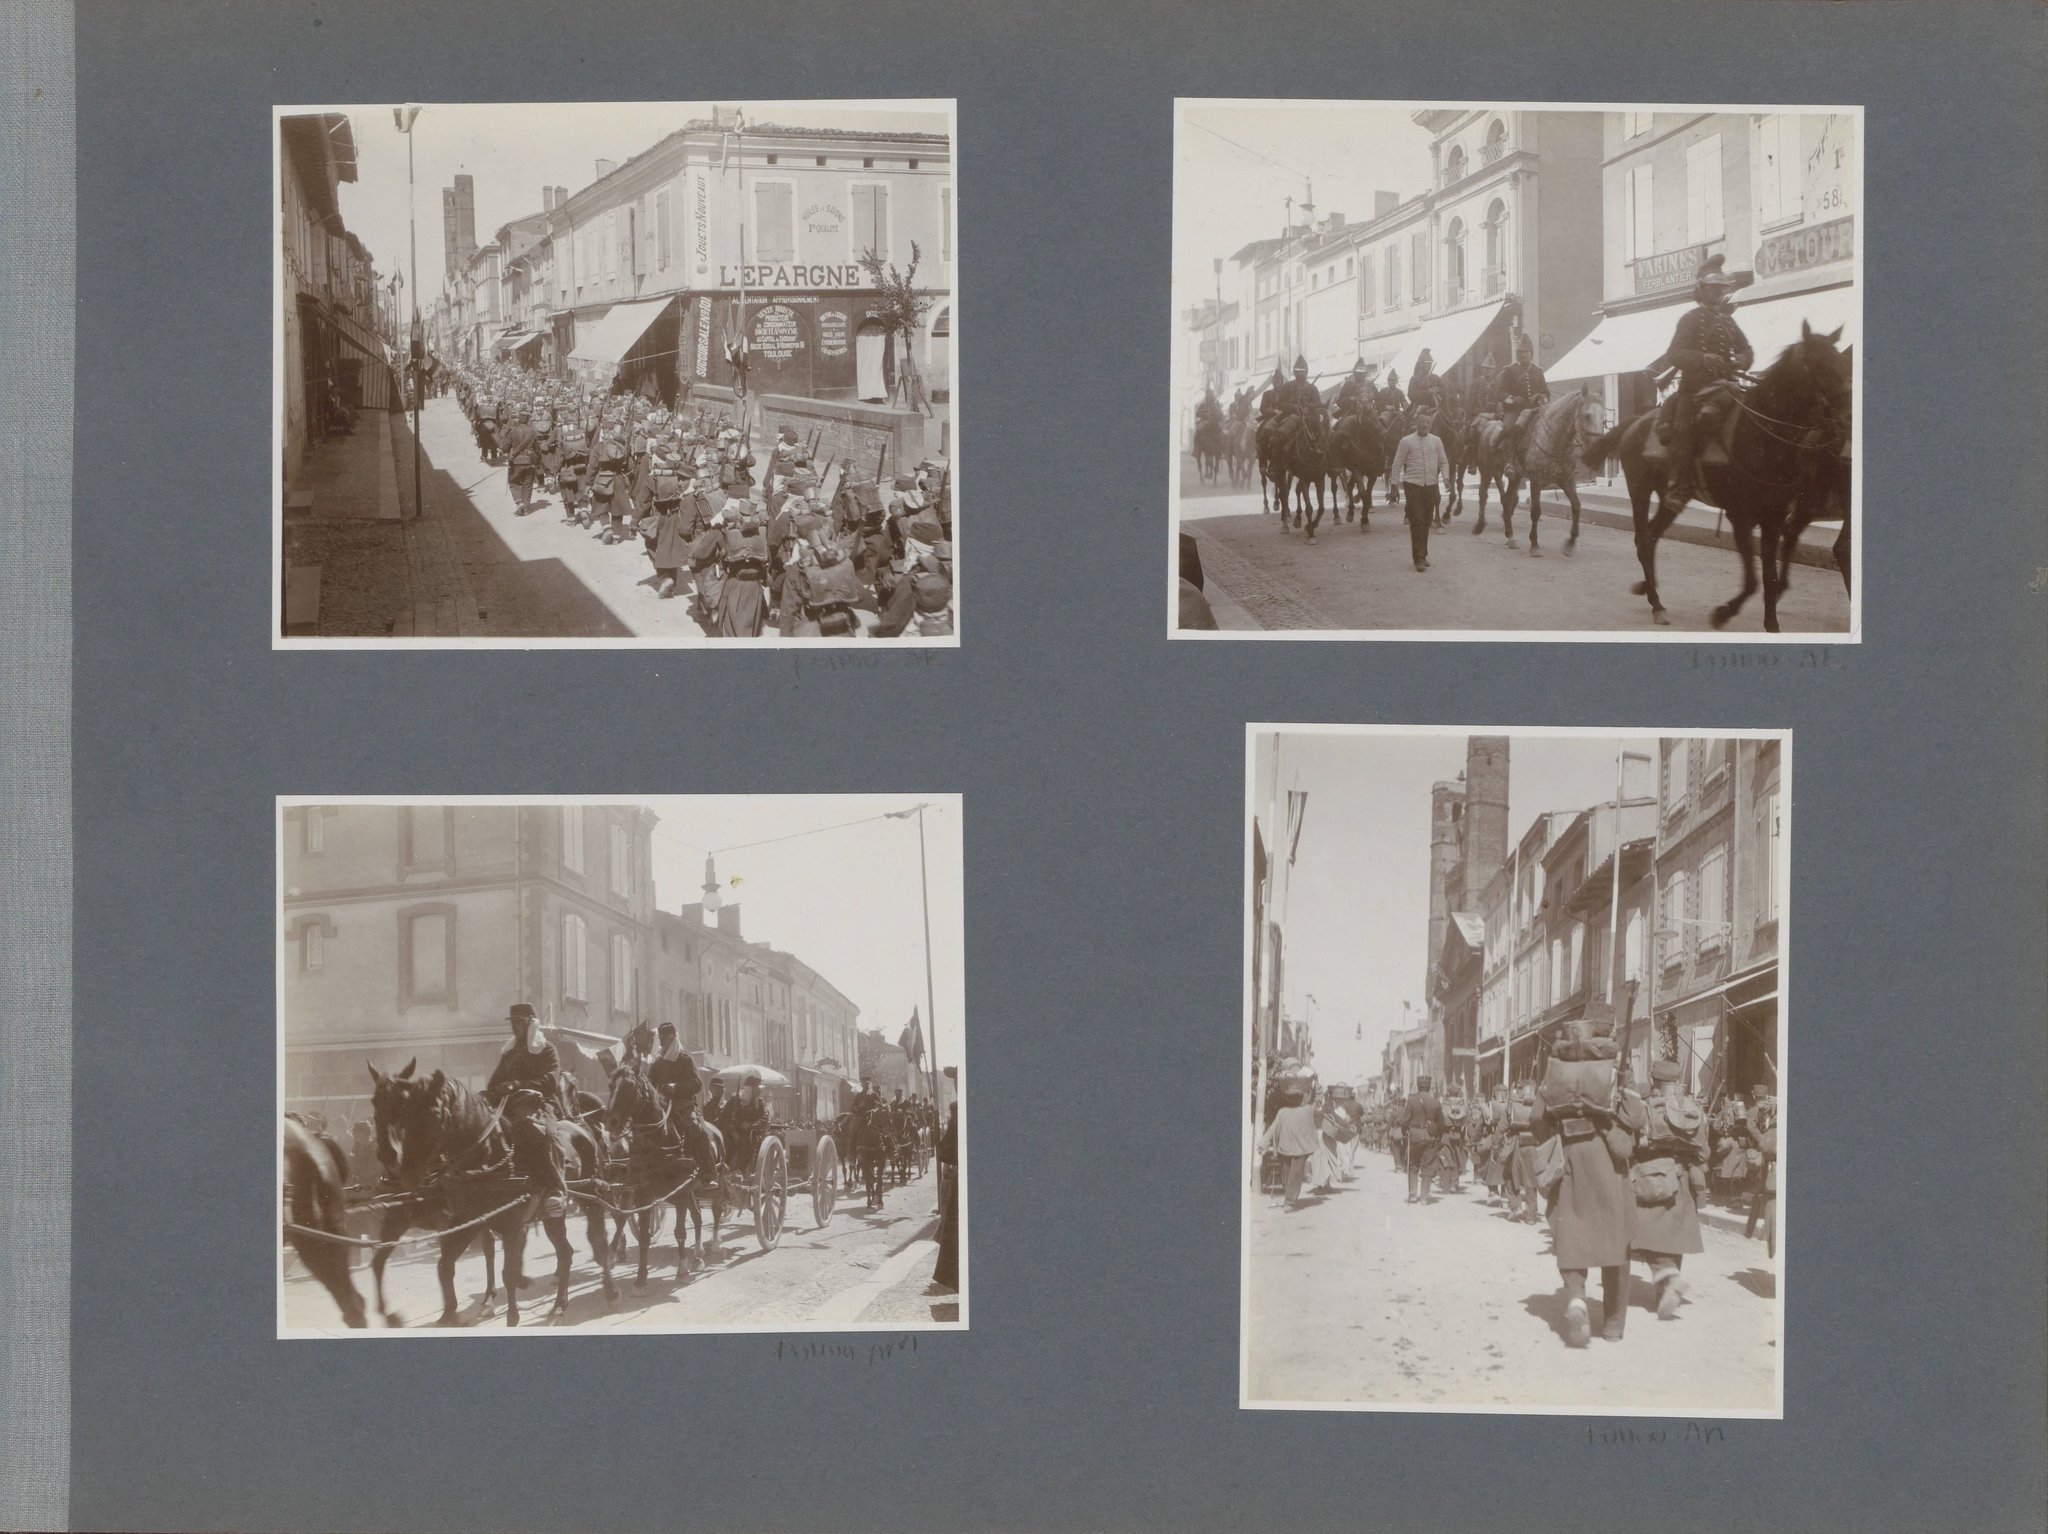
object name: album leaf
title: Intocht van militairen in een stad in Frankrijk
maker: Anonymous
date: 1902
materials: paper, photographic support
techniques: daylight paper print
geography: france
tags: marching away (troops), land forces, france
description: Onderdeel van Fotoalbum van een legeroefening in Zuidwest-Frankrijk in 1902.